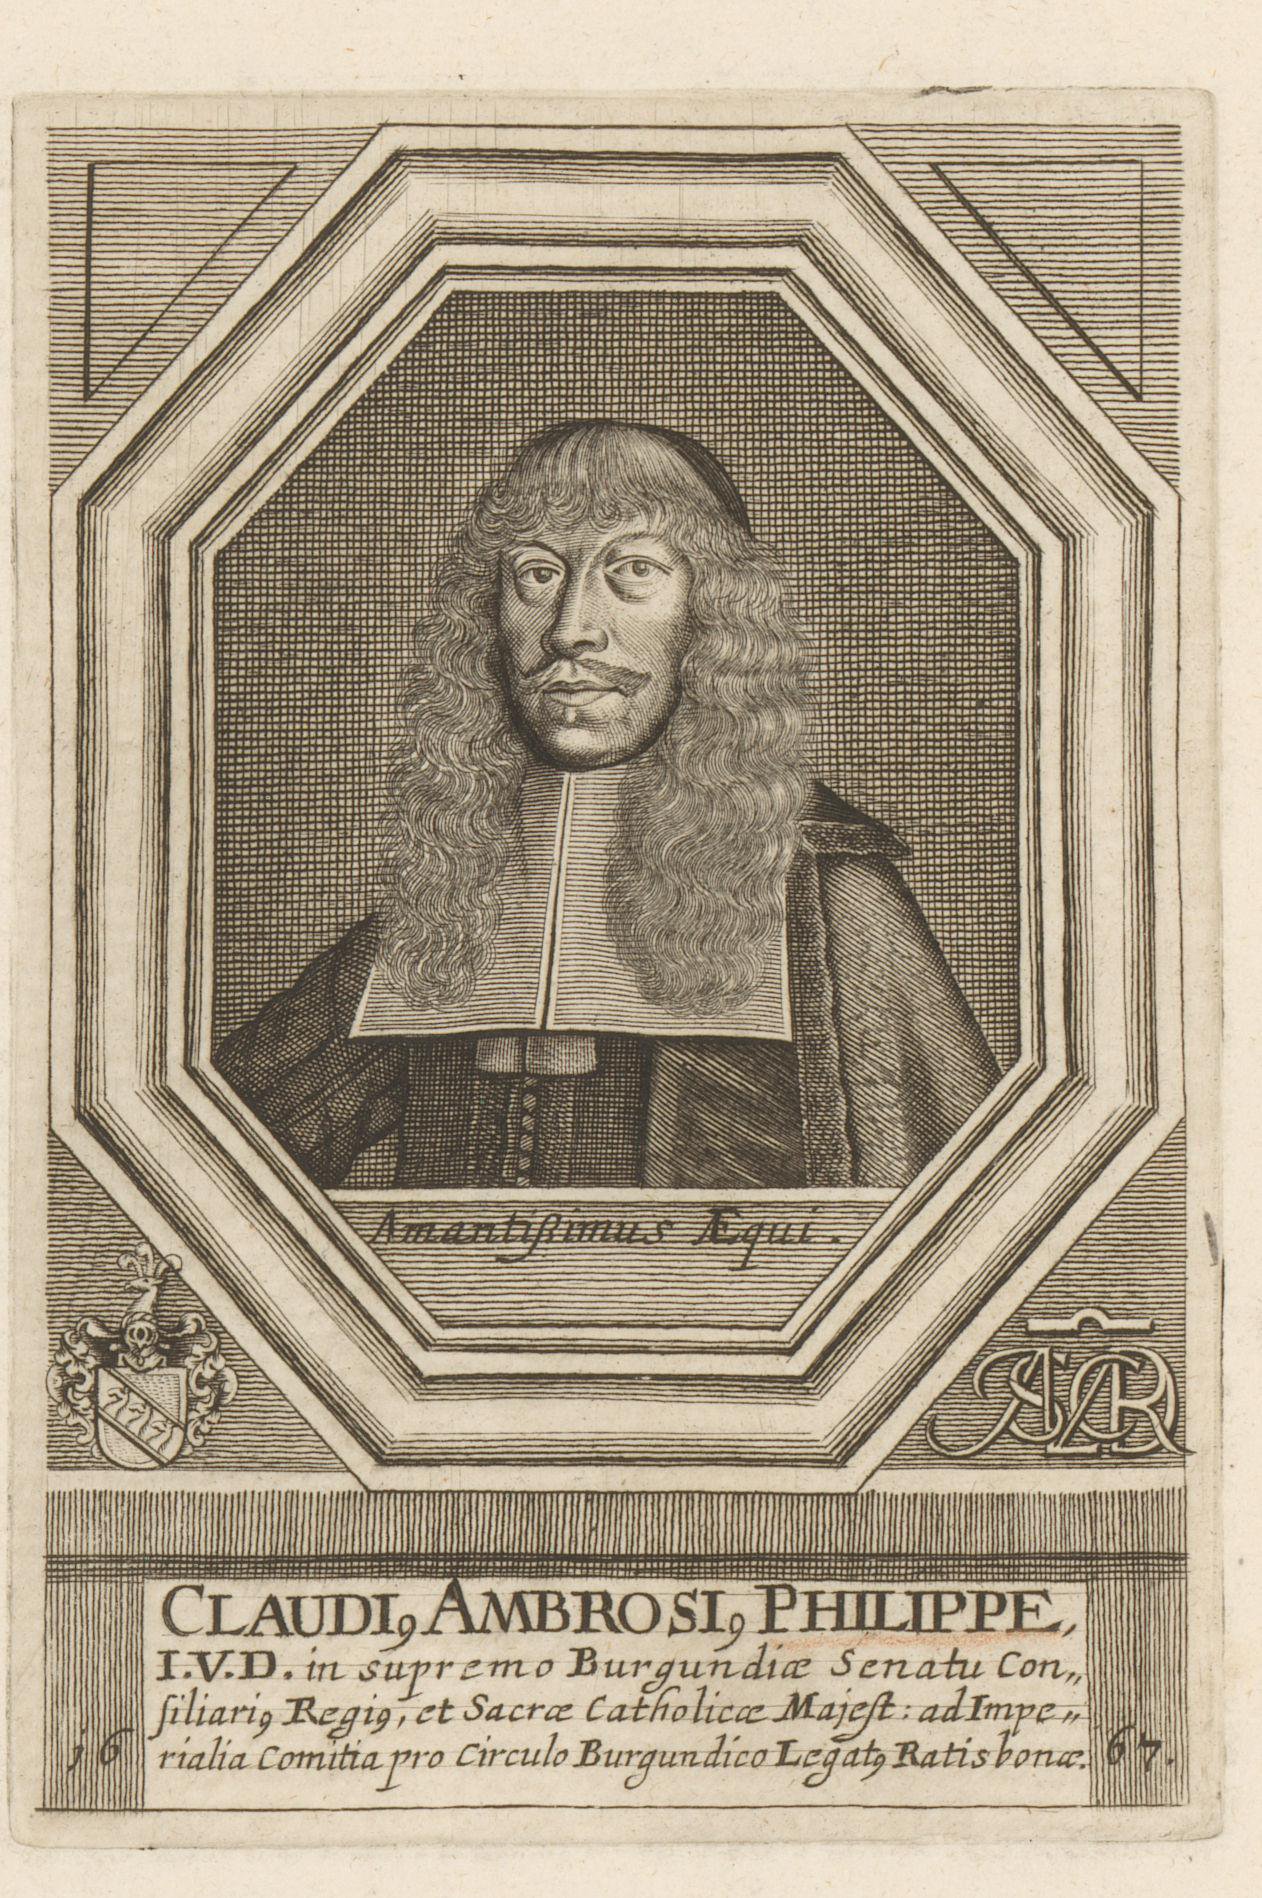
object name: print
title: Portret van Claude-Ambroise Philippe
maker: matthias van sommer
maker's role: draughtsman, print maker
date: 1667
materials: paper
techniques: engraving, etching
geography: germany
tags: historical persons, armorial bearing, heraldry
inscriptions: collector's mark: Lugt 2228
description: Volgens Hollstein werd de prent gebruikt voor de publicatie: Sommer, Matthias van. Hasce Omnium Electorum. Regensburg: s.n., 1667. Alhoewel op de titelpagina van de publicatie het jaar 1667 wordt vermeld, zijn meerdere prenten later gedateerd. Waarschijnlijk werd de publicatie pas in 1671 daadwerkelijk uitgegeven.